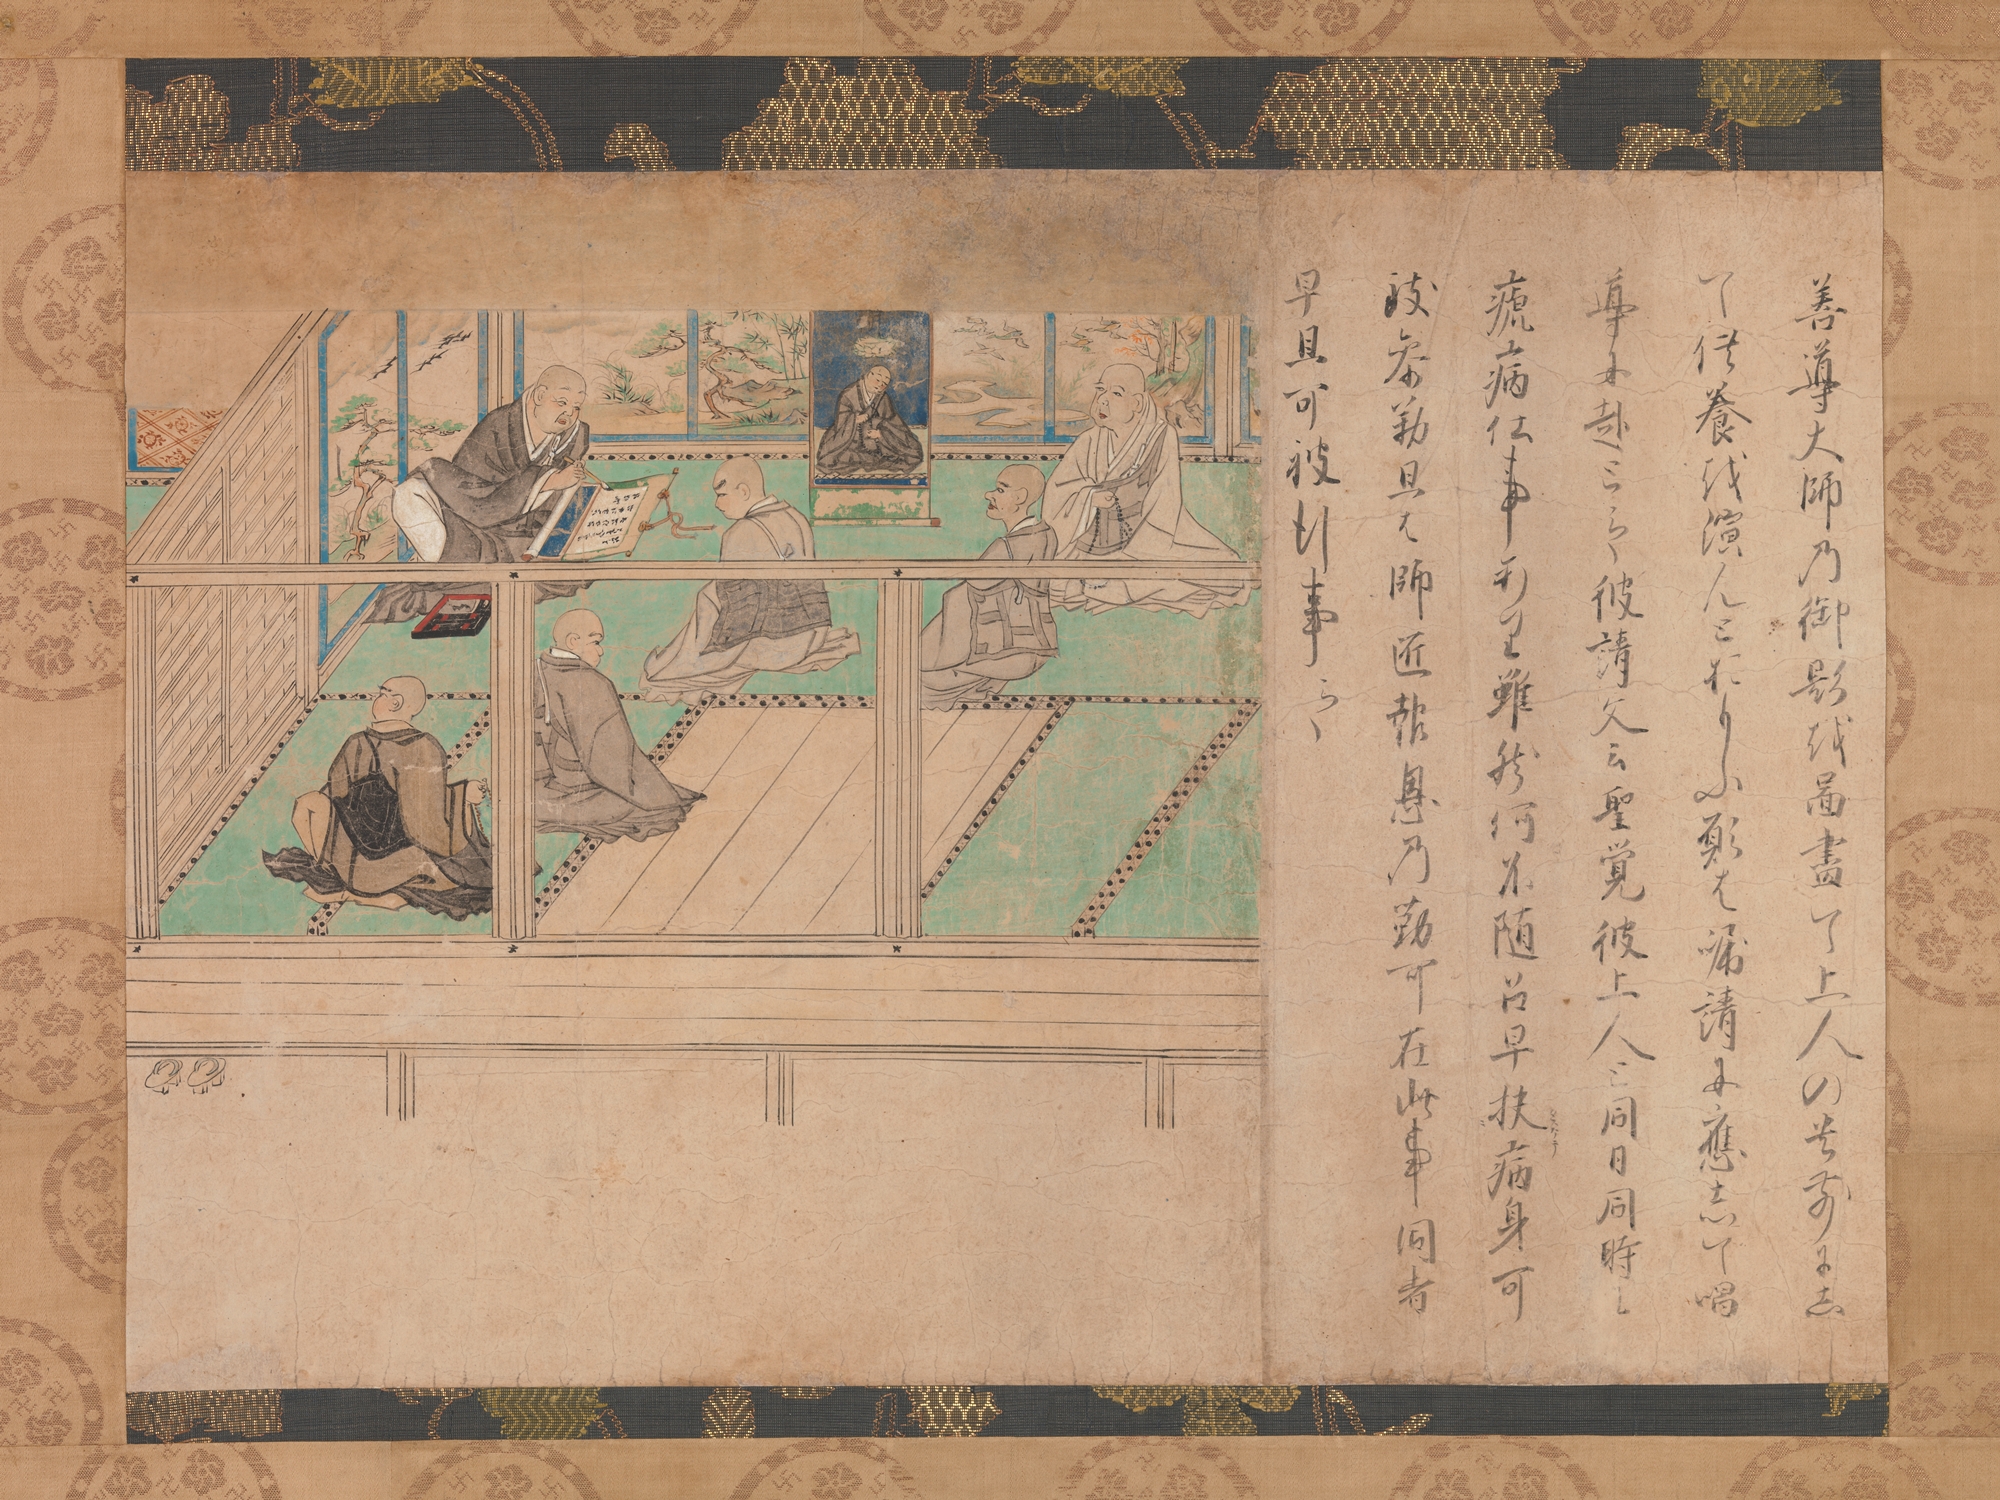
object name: hanging scroll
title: Illustrated Biography of Hōnen (Shūikotokūden-e)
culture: japanese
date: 1310-1320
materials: ink, paper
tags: men,buddhism,monks,calligraphy